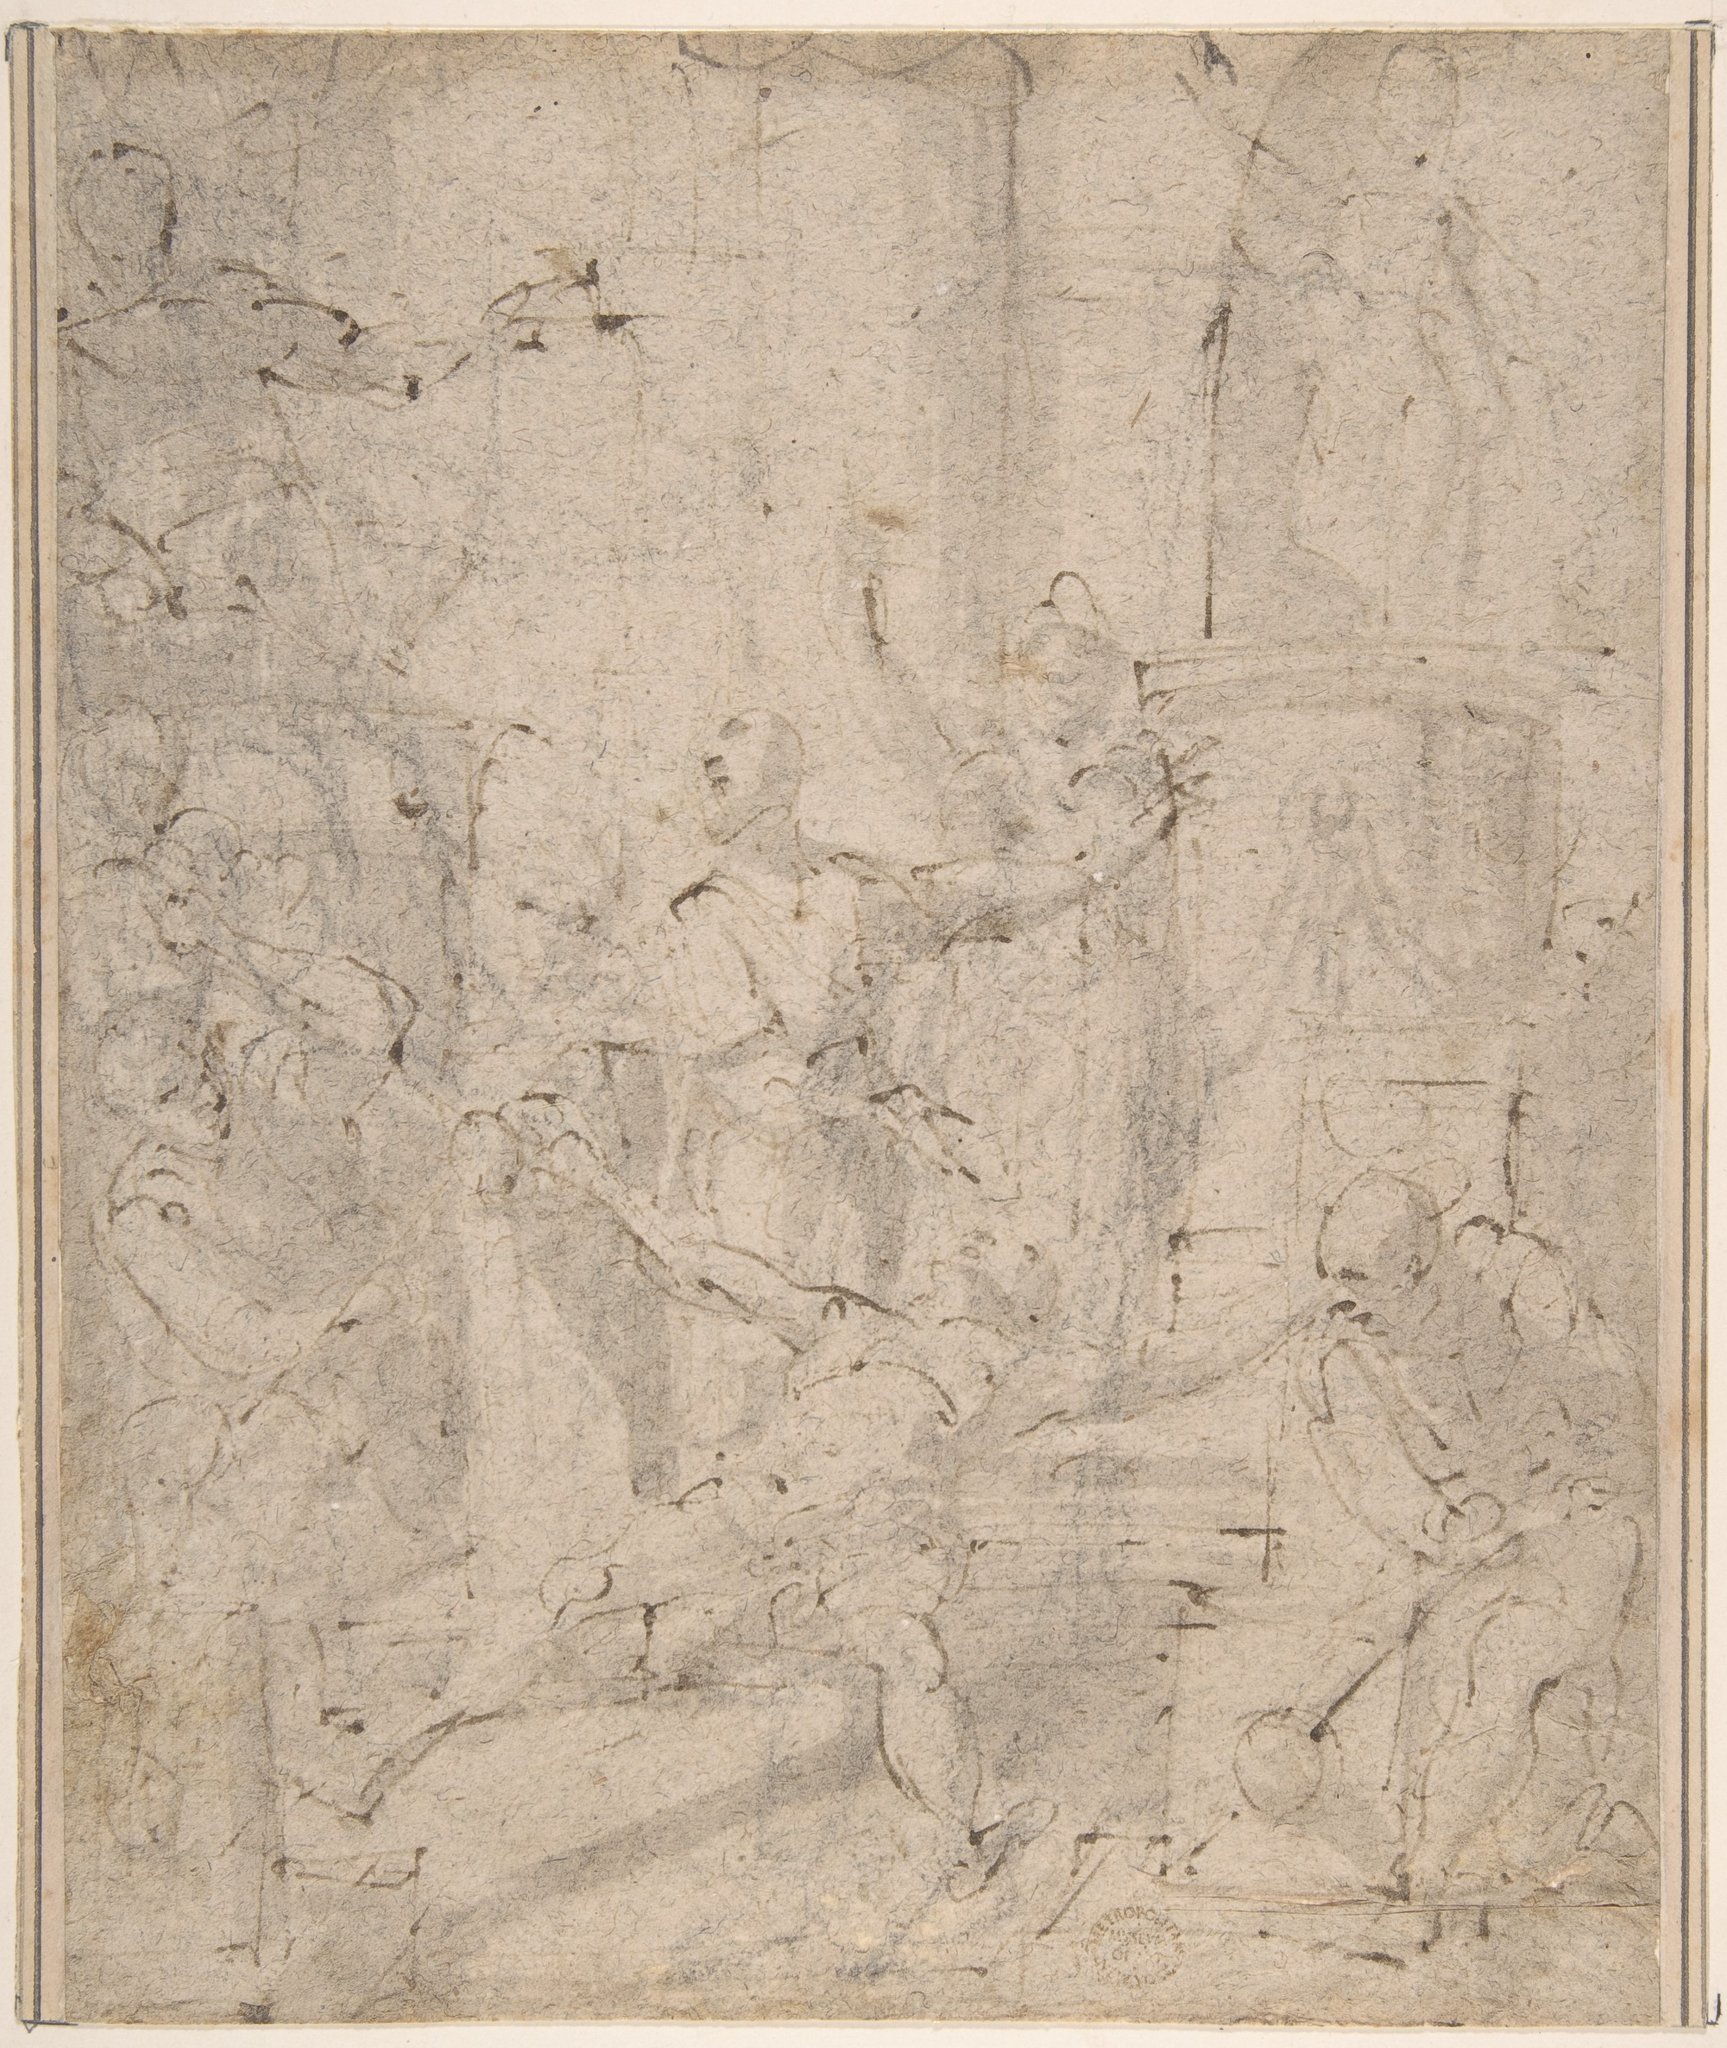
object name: drawing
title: Martyrdom of Saint Andrew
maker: anonymous, italian, roman-bolognese, 17th century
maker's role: artist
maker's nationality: italian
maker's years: 1600-1700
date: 1601-1700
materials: charcoal, ink, paper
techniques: brush, pen, wash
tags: men,saints